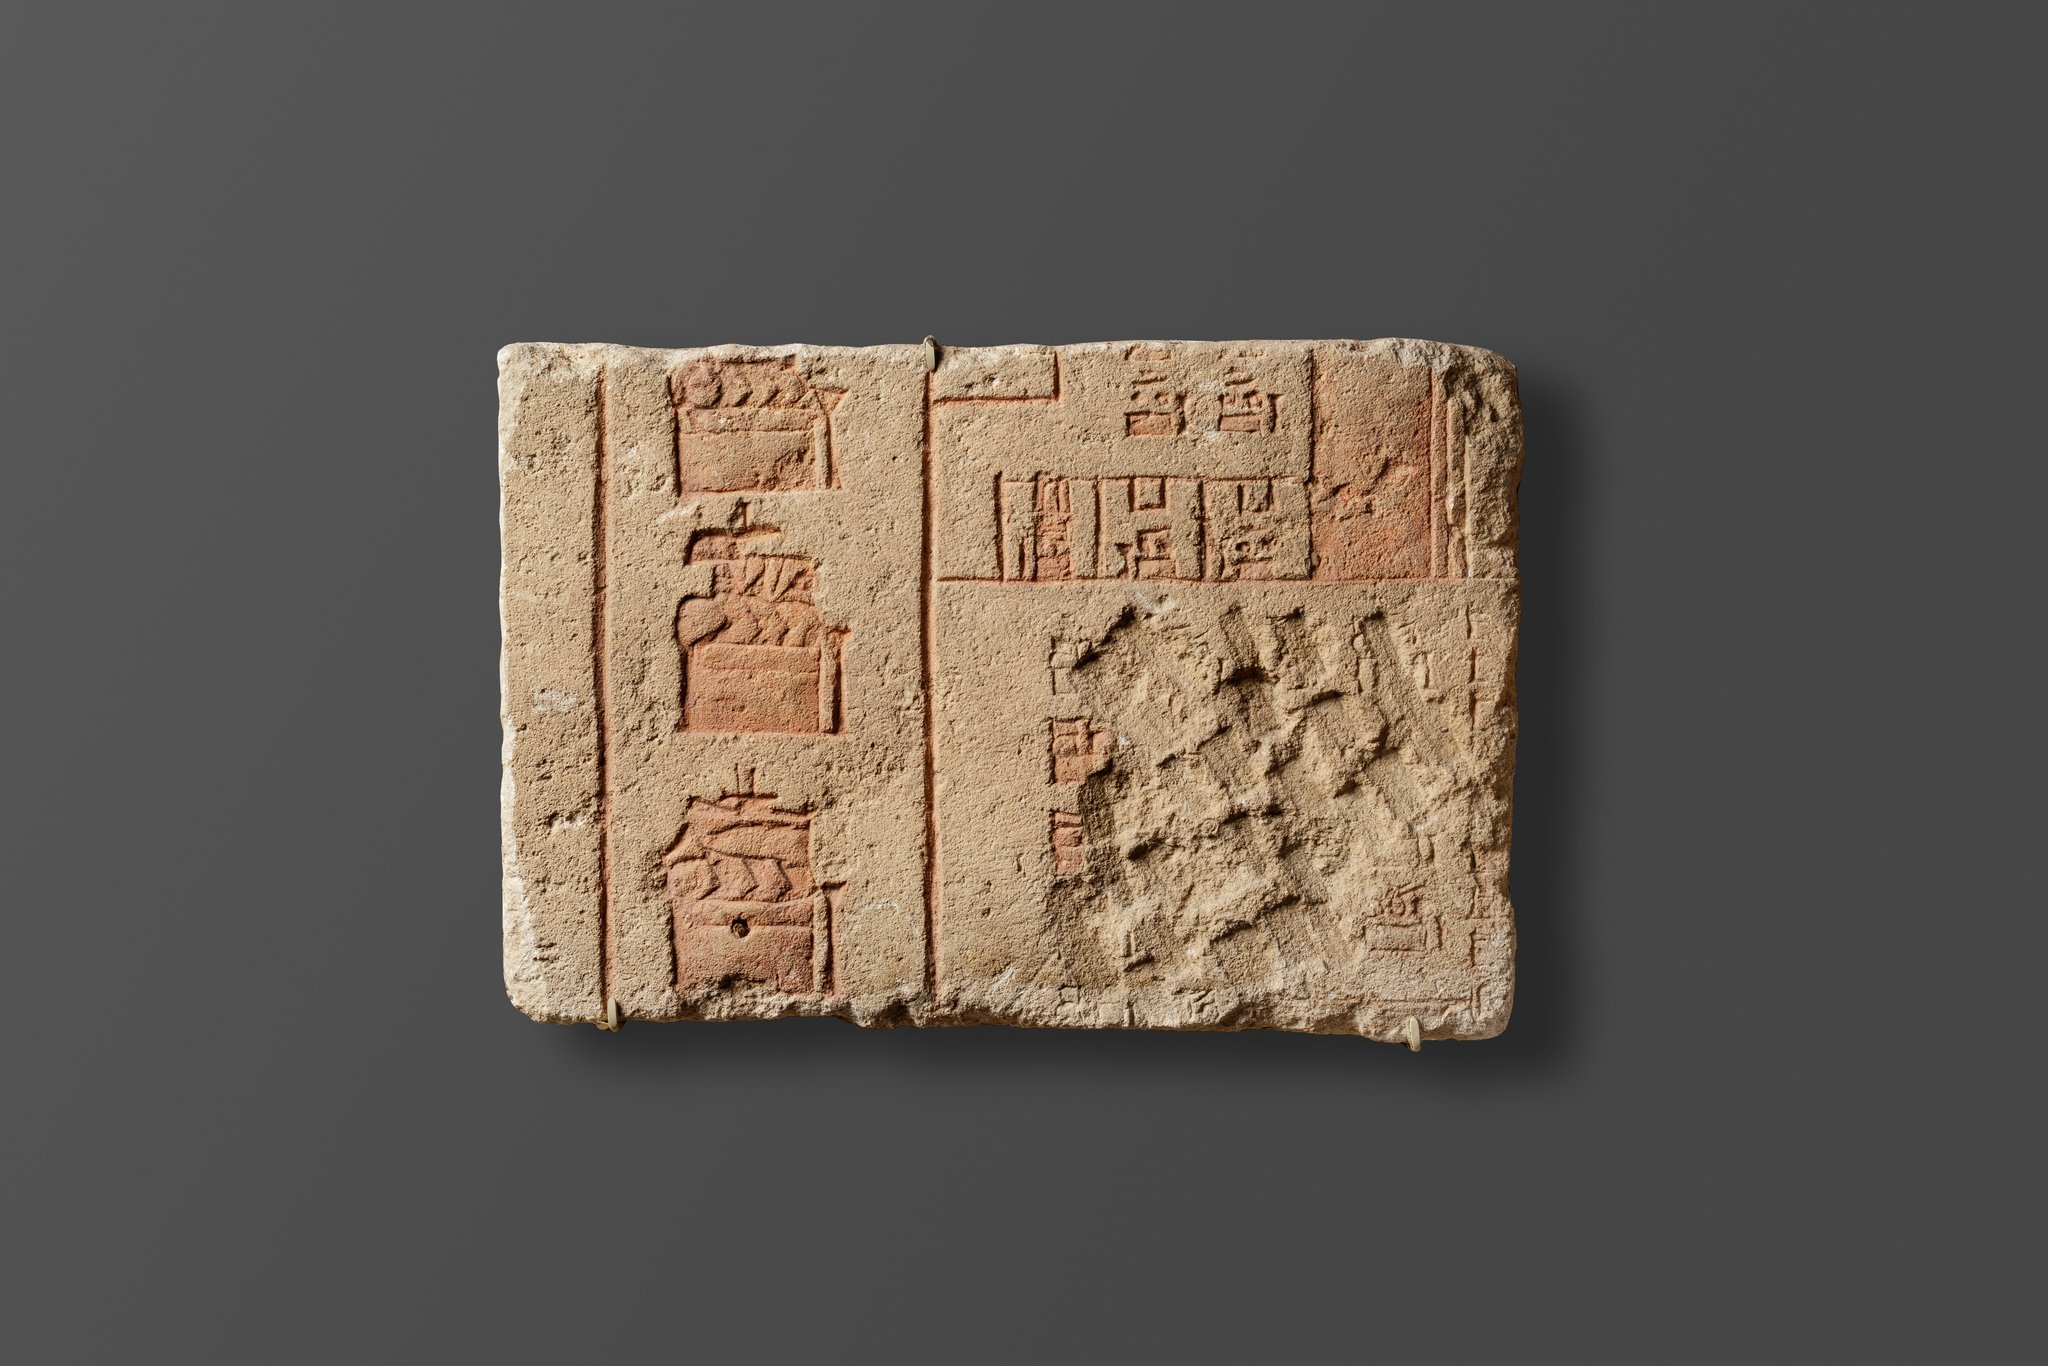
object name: talatat, temple scene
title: Relief with a temple scene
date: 1353-1336 BCE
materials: limestone, paint